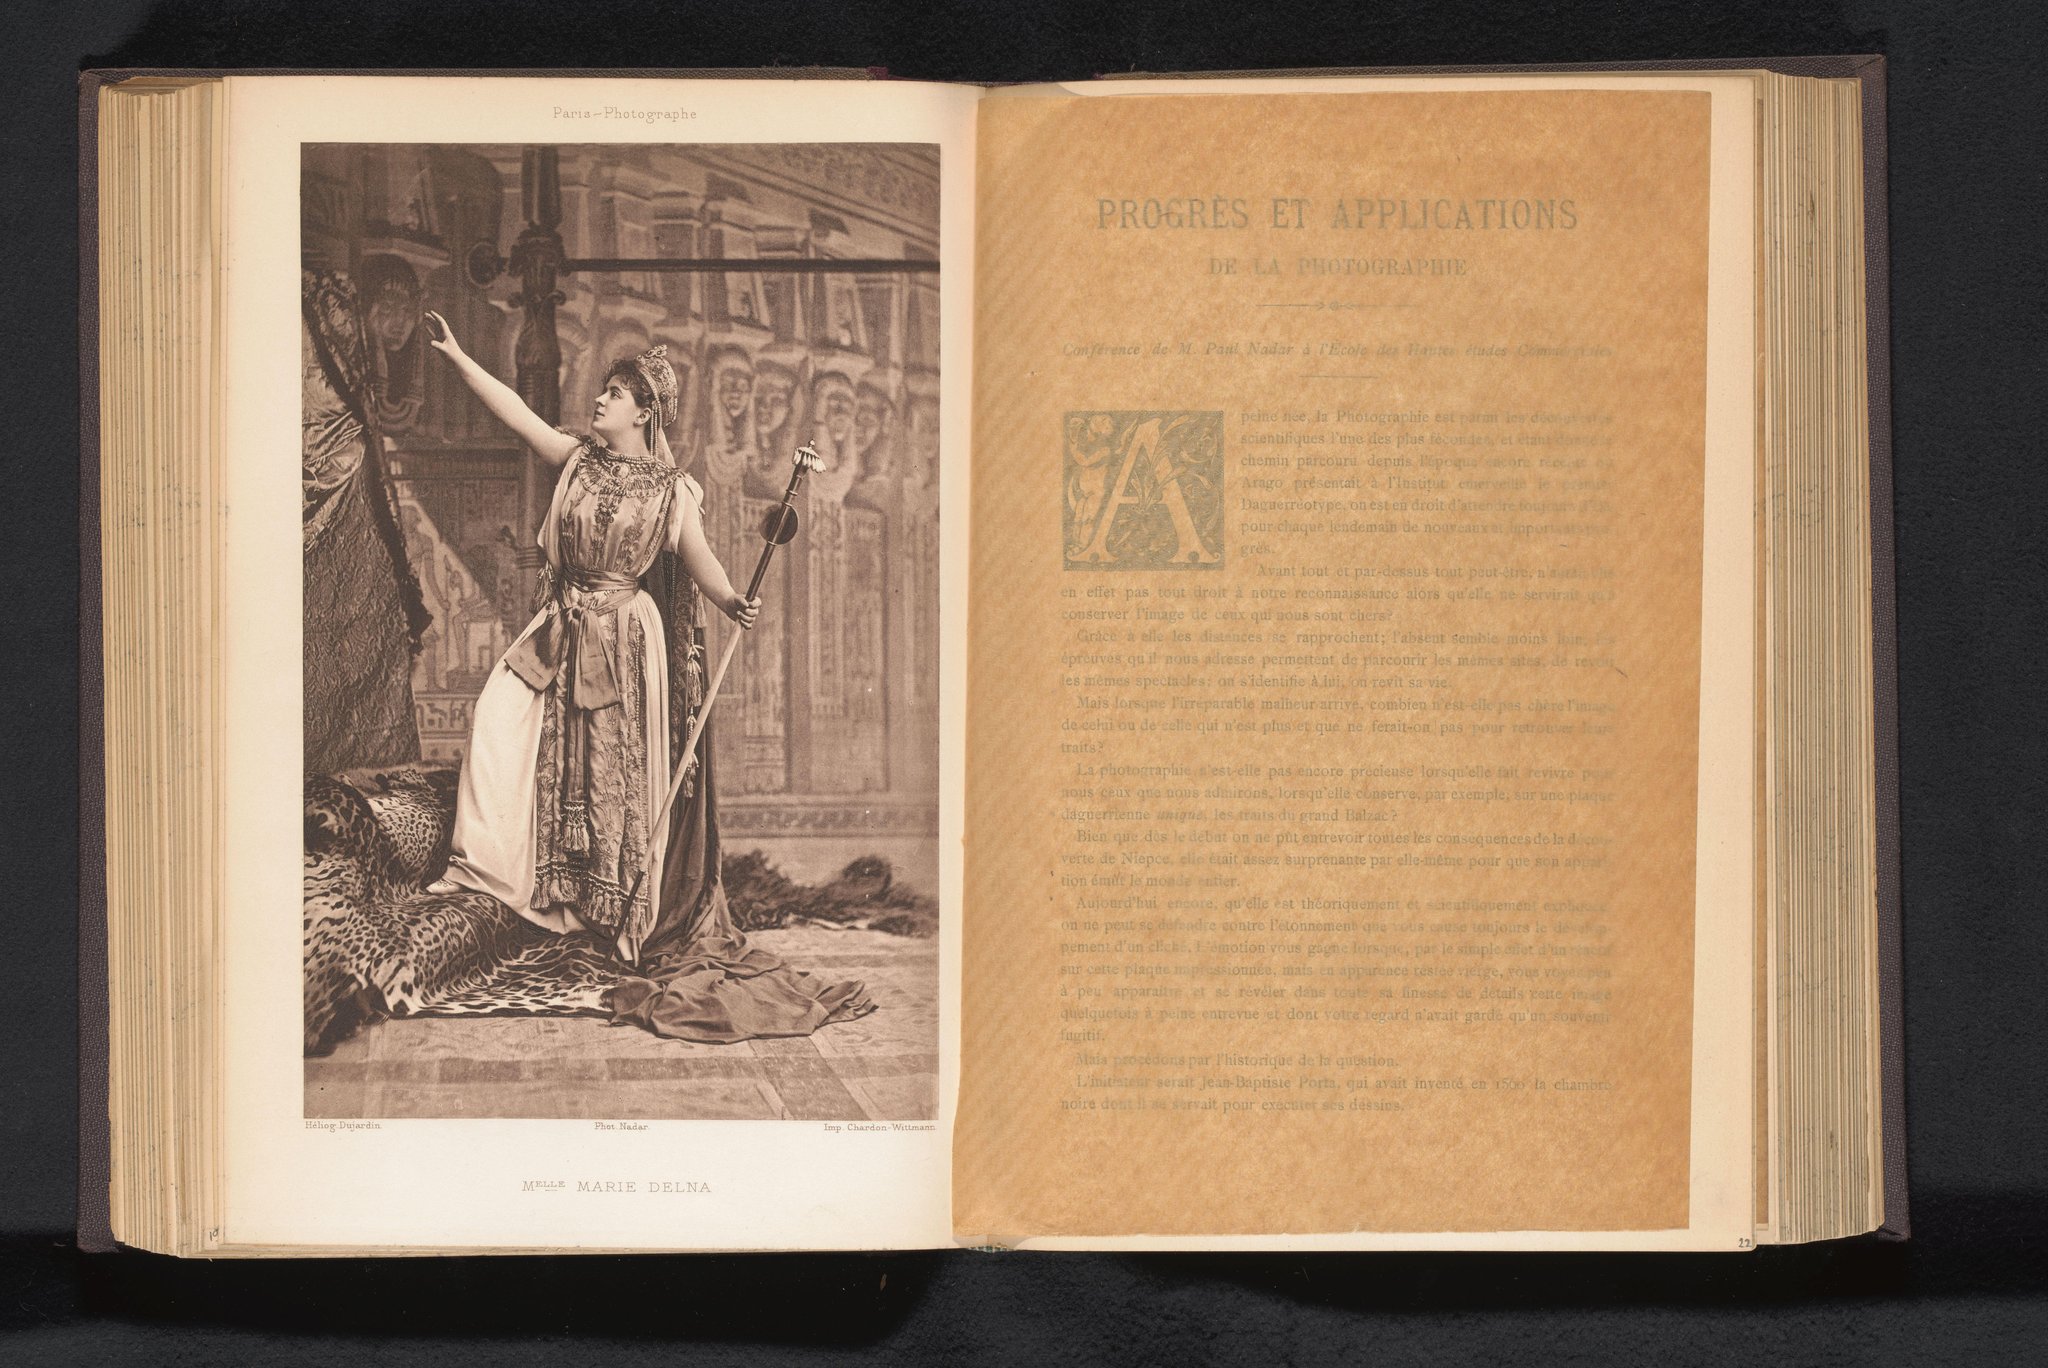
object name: photomechanical print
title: Portret van Marie Delna in een theaterkostuum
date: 1890-1892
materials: paper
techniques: photoaquatint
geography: paris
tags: paris, opera-singer (female)